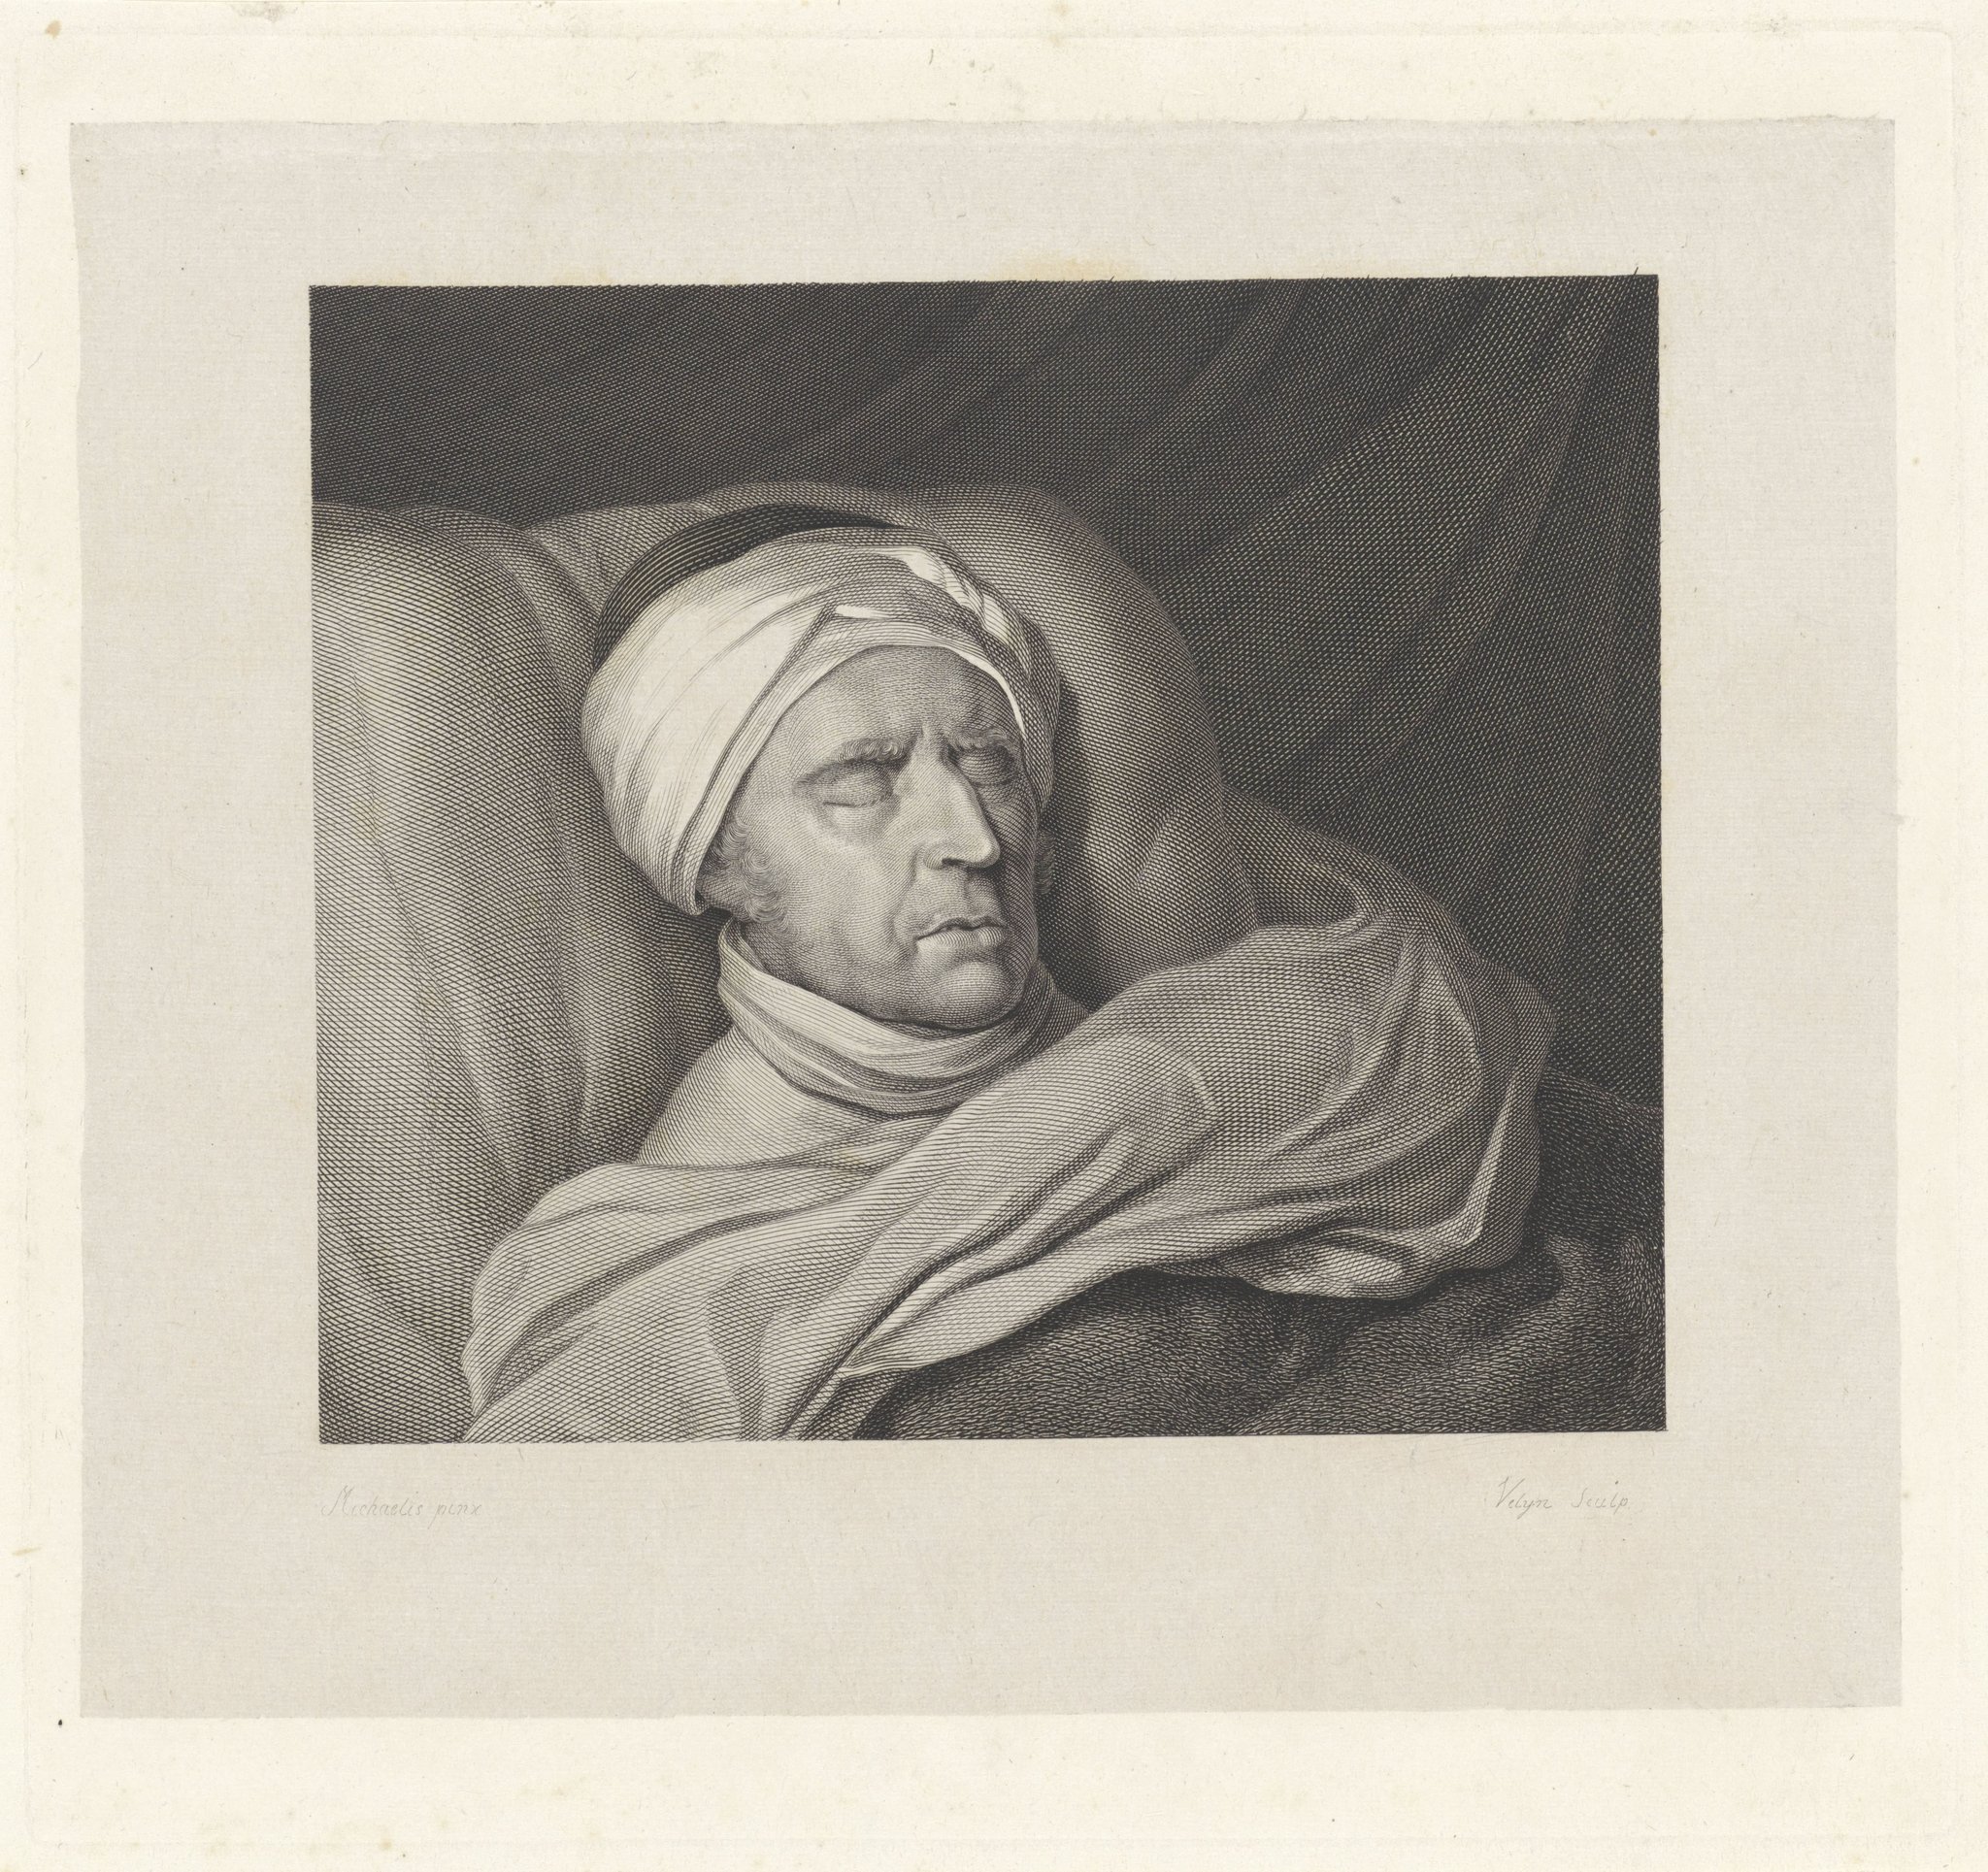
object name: print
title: Willem Bilderdijk op zijn doodsbed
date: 1833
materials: paper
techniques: engraving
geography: netherlands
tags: amsterdam, haarlem, print maker, draughtsman, willem bilderdijk, deathbed, artist on his deathbed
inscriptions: collector's mark: Lugt 2228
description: De geschiedschrijver en dichter Willem Bilderdijk op zijn doodsbed.